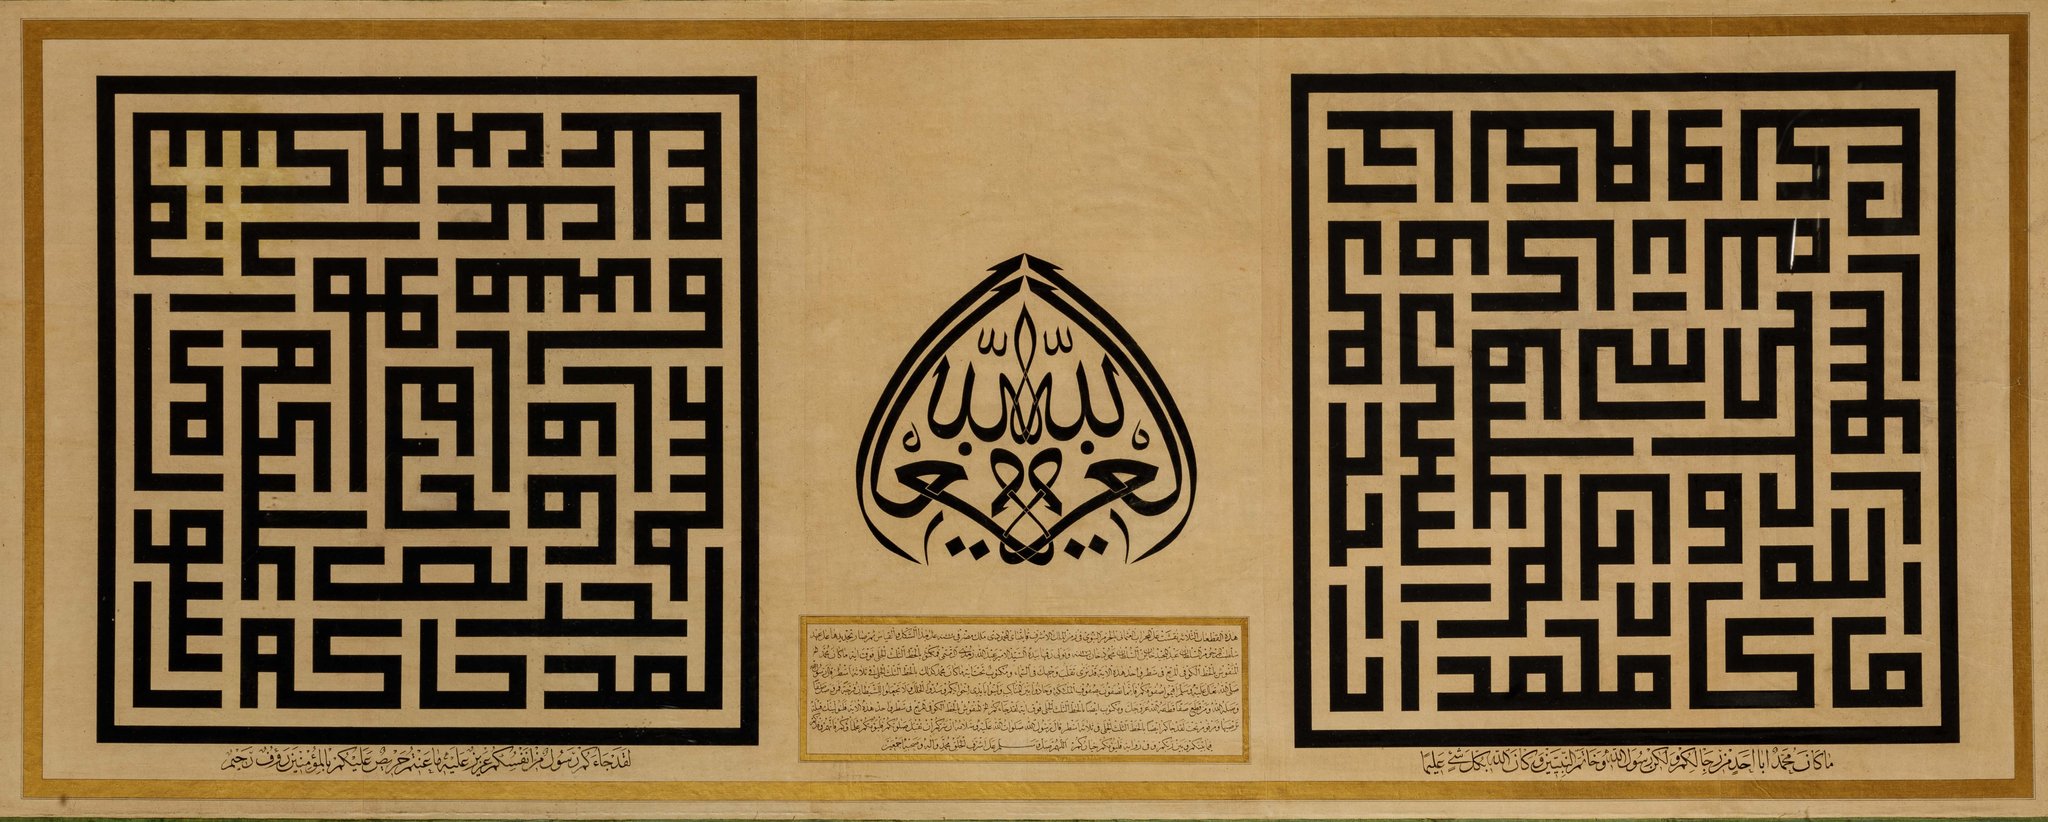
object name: calligraphic composition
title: Monumental Calligraphic Composition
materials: gold, ink, paper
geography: turkey